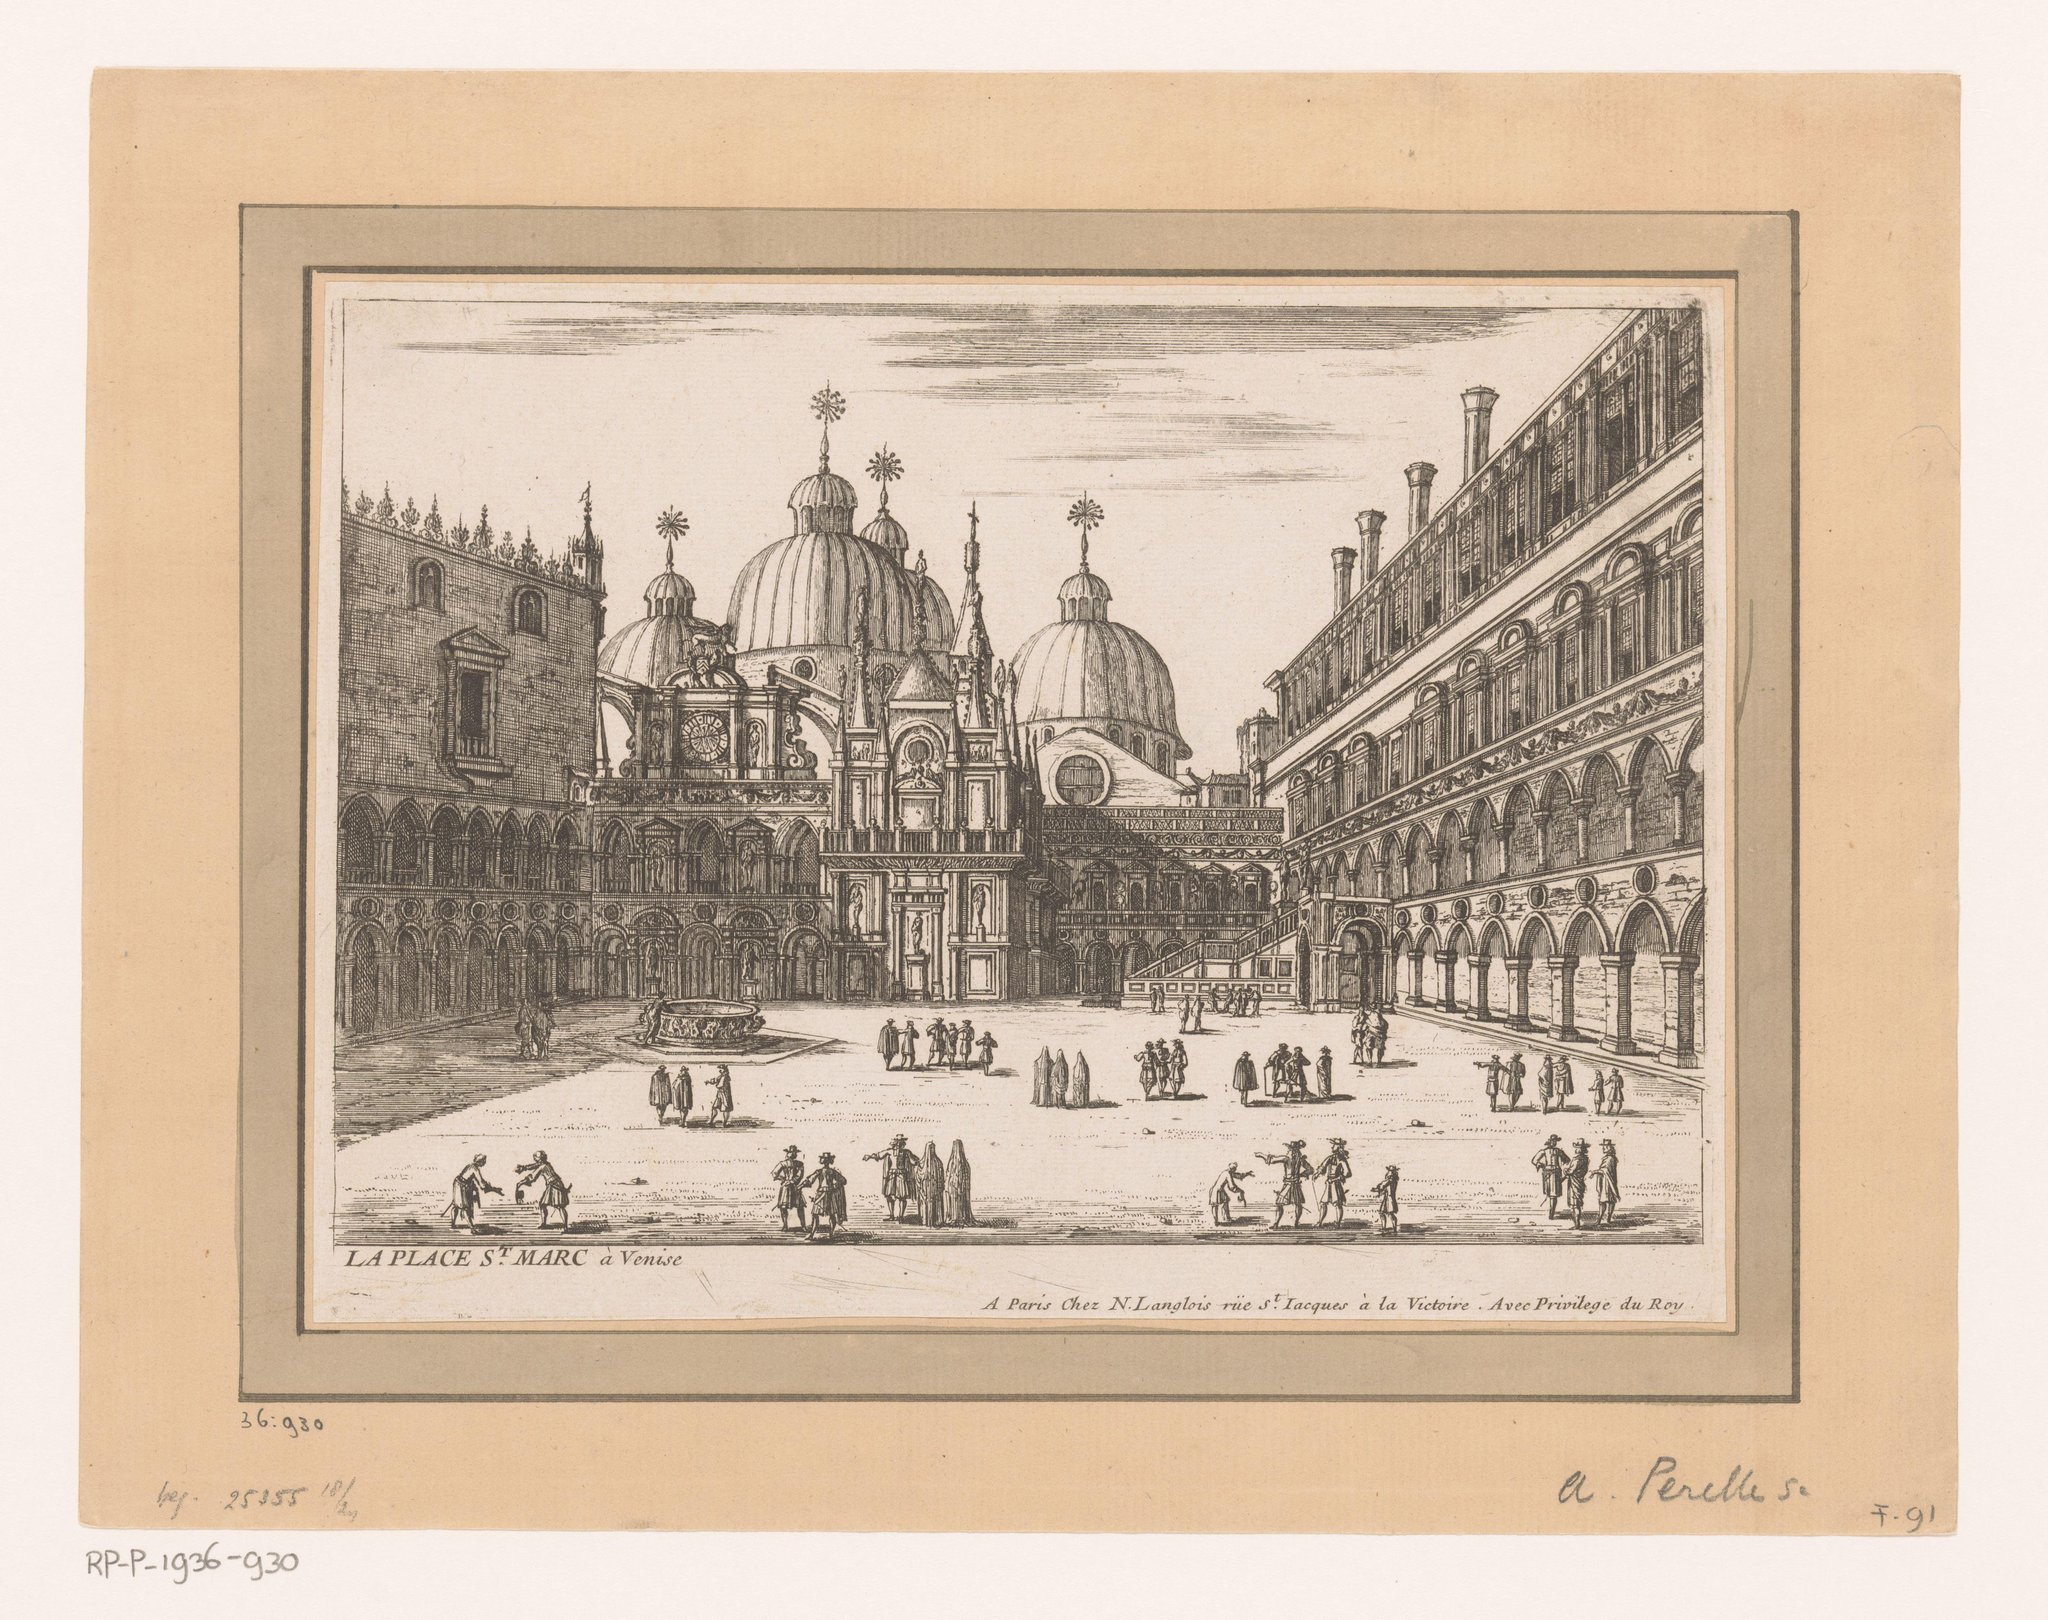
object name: print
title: Gezicht op het San Marcoplein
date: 1671-1695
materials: paper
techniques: etching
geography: paris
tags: san marcoplein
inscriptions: collector's mark: Lugt 2228